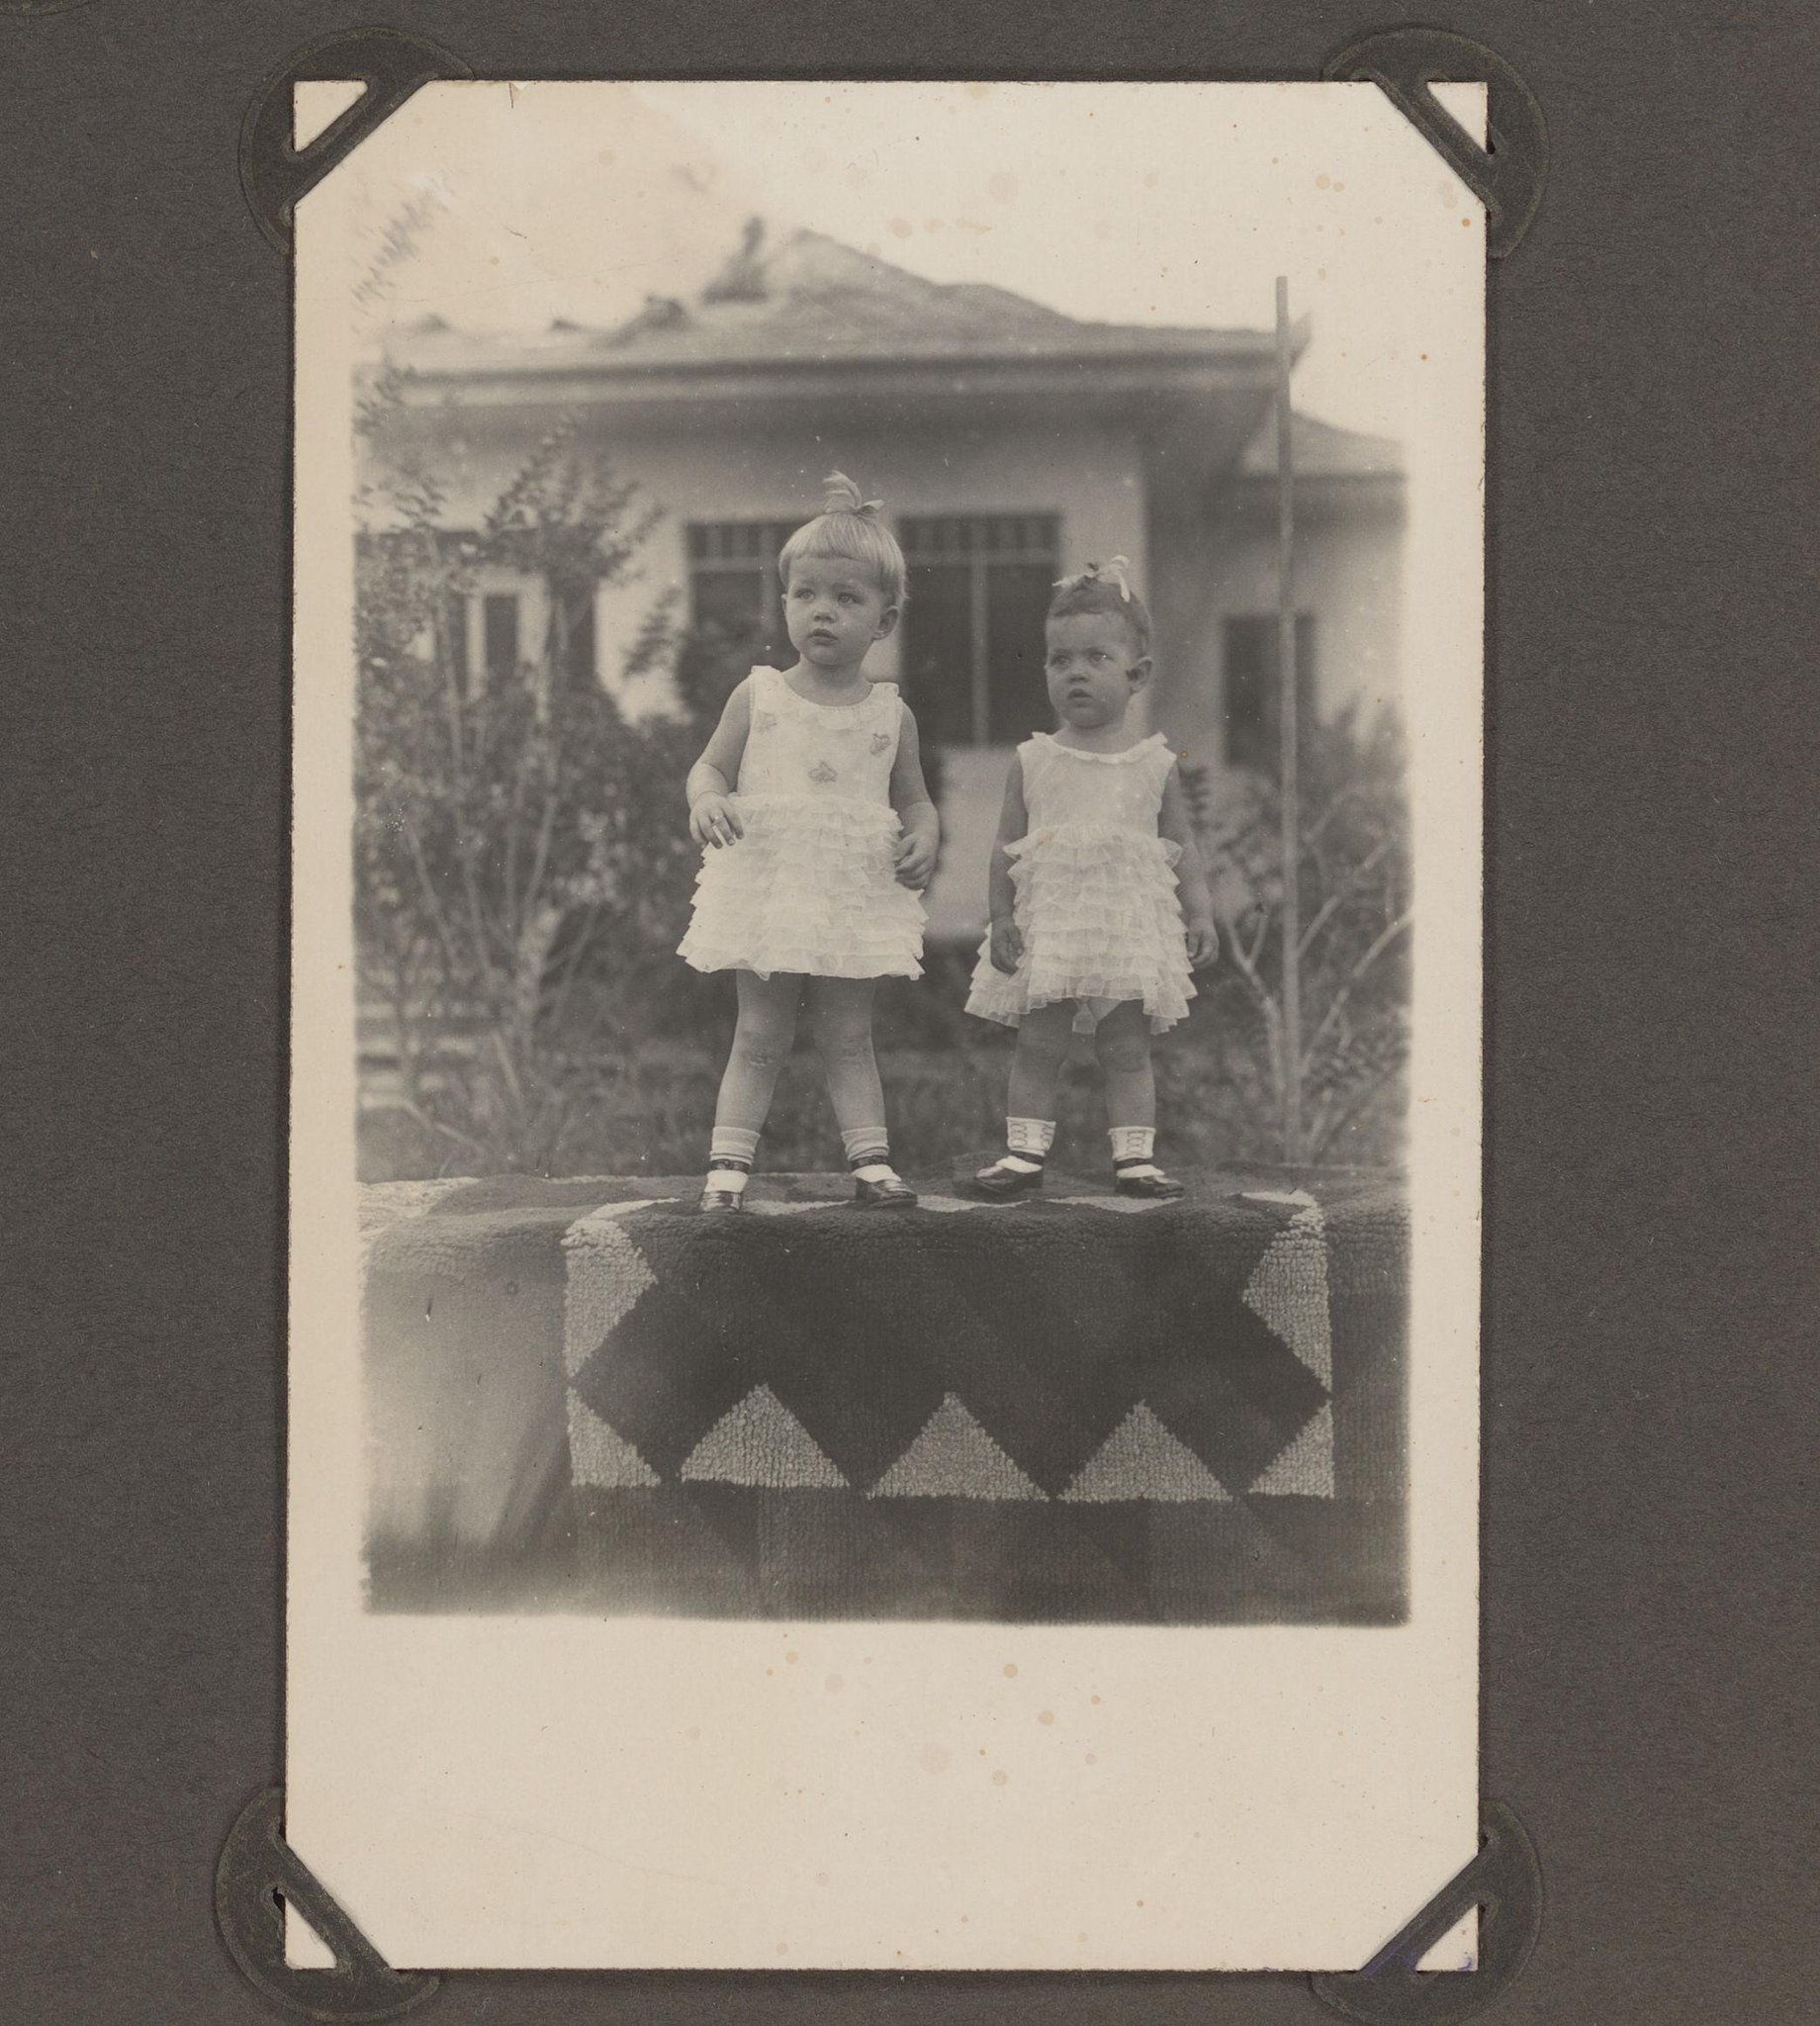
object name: photograph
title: Familiefoto van het gezin Jetten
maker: Anonymous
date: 1925-1927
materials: photographic support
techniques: photography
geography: suriname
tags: jetten, familie, moengo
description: Familiefoto van de kinderen Jetten, soms met de ouders. Verjaardagsfeestje. Foto op een bladzijde van een los albumblad. Onderdeel van het ensemble met foto's van de familie van ingenieur Jetten in de mijnbouwstad Moengo in Suriname.